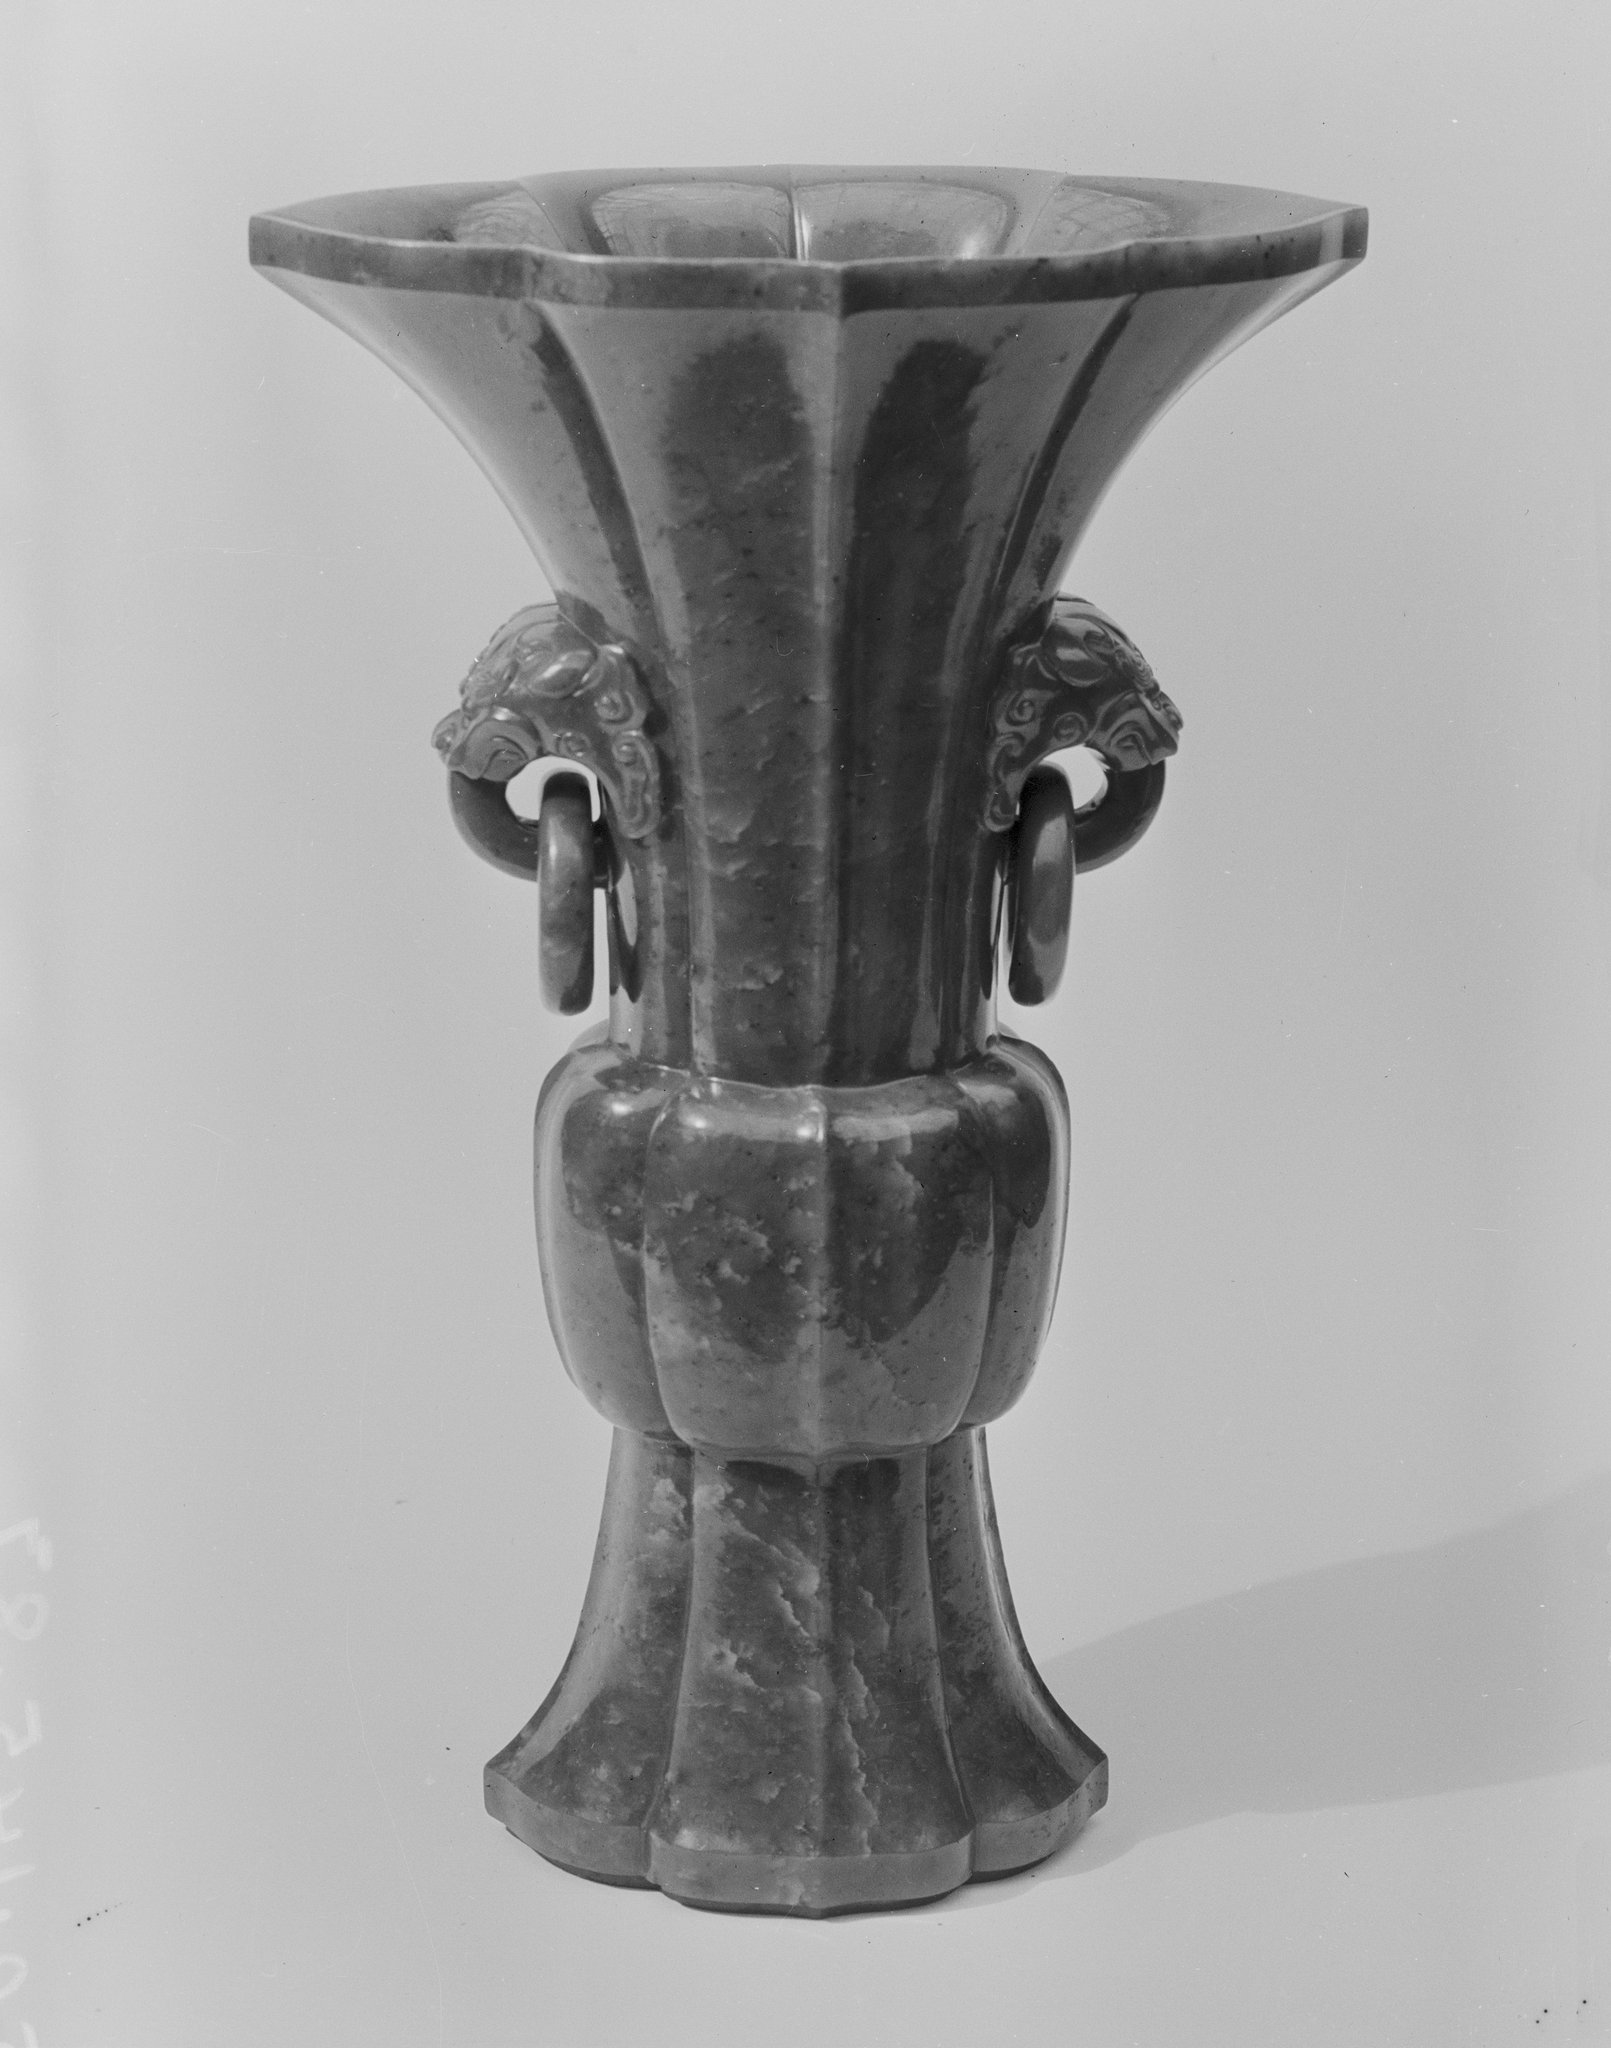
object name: vase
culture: chinese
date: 1701-1800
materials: jade